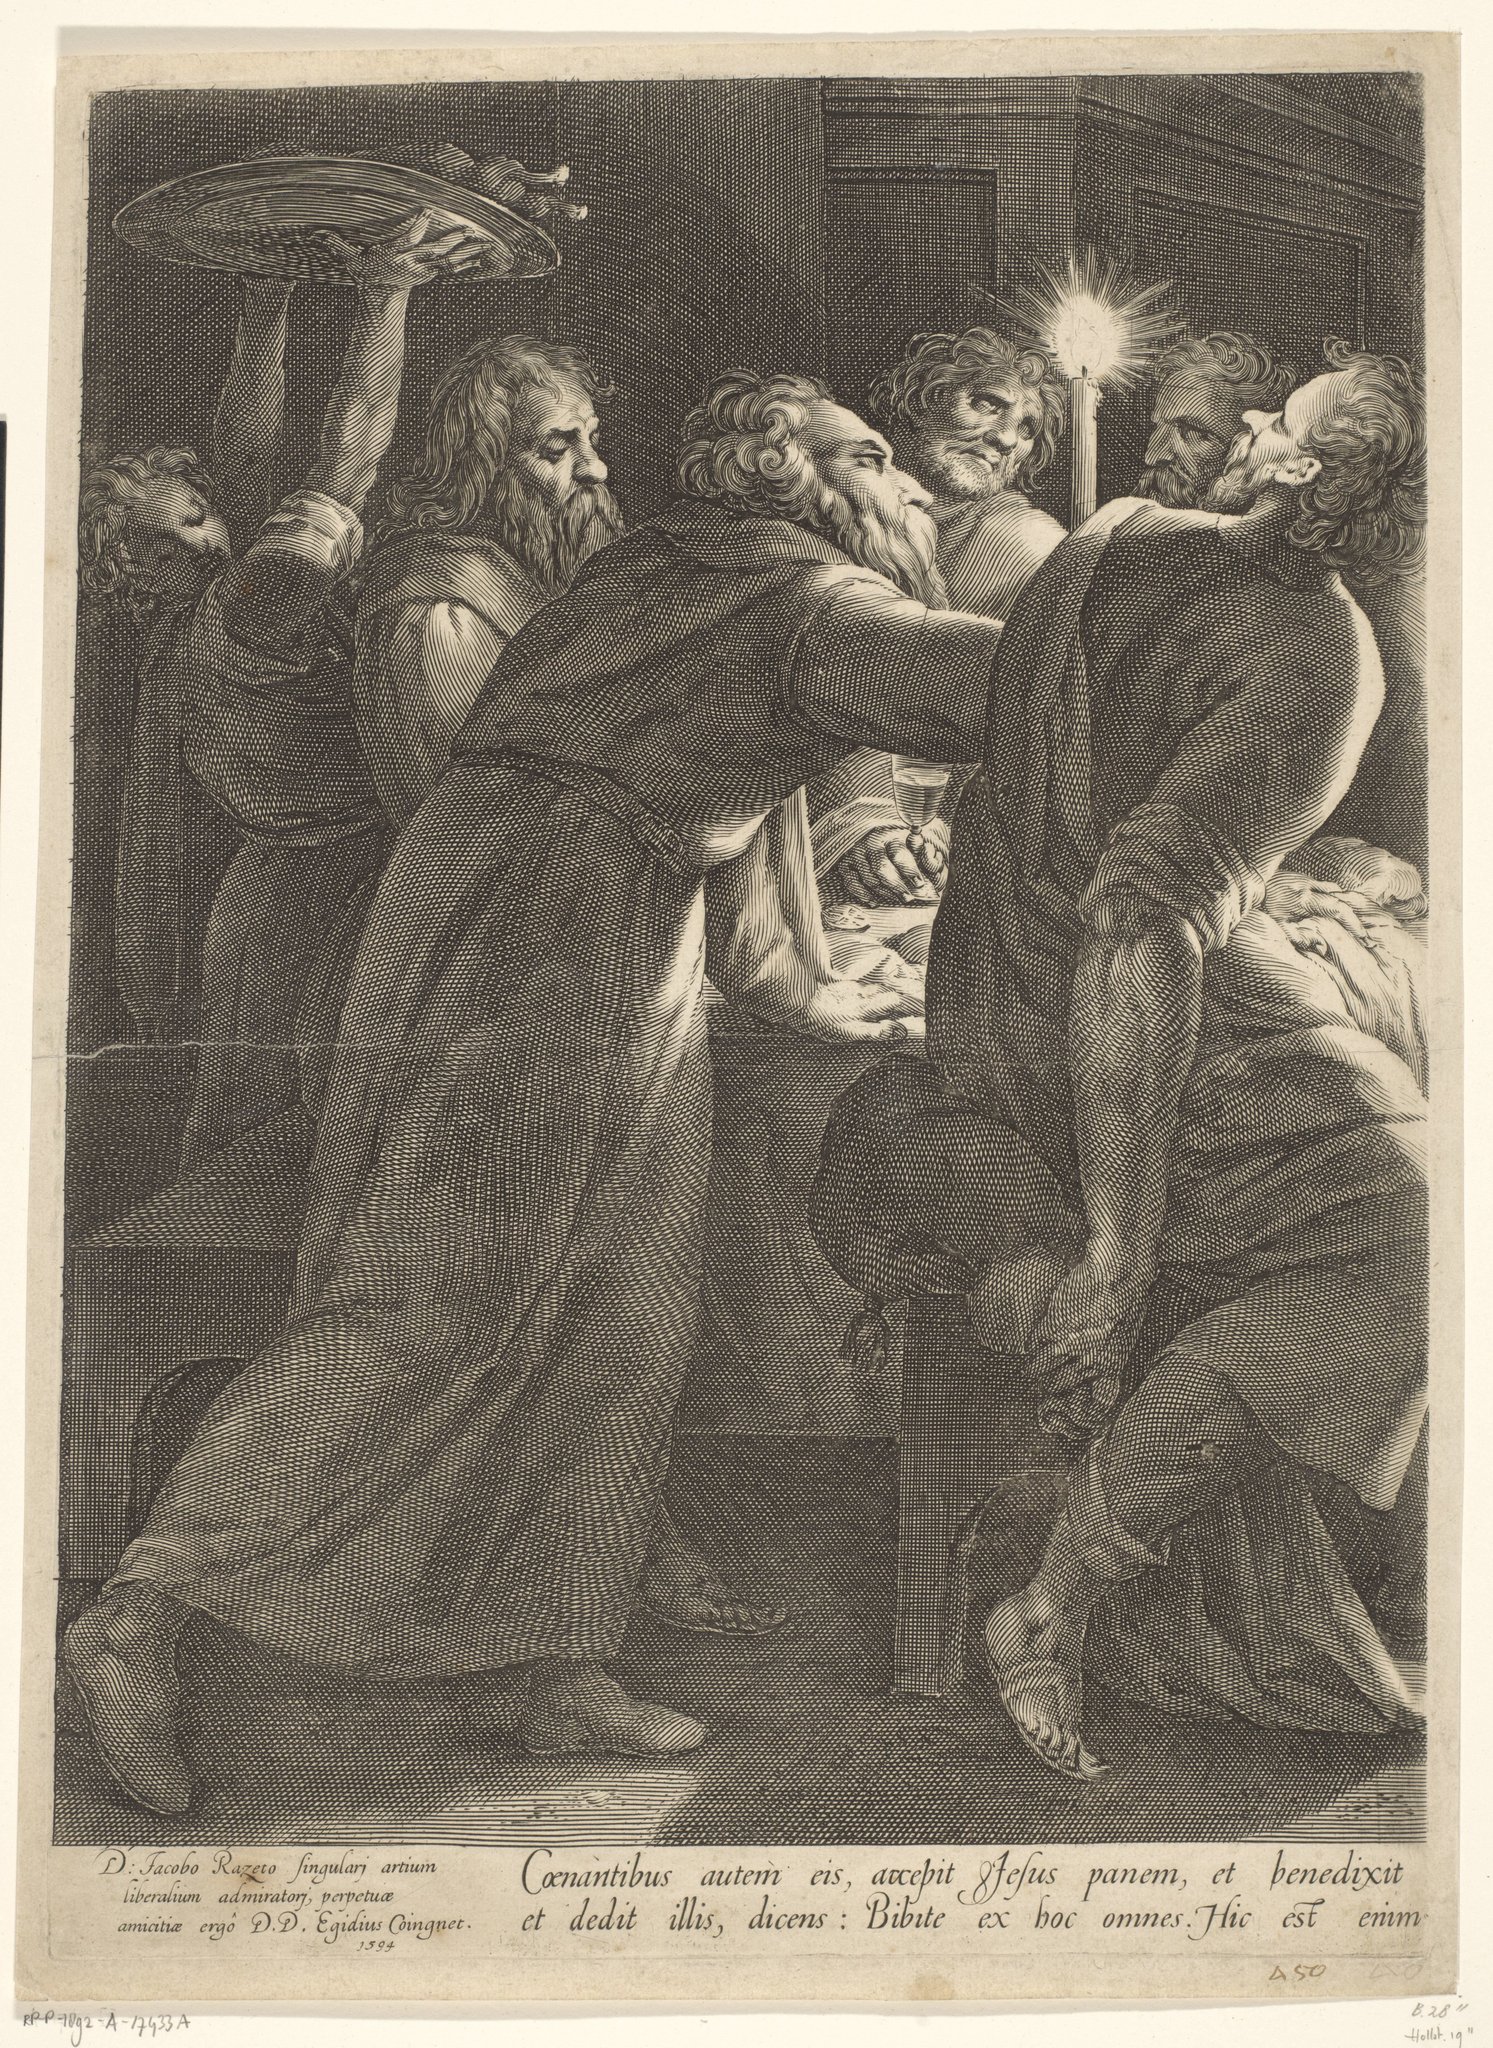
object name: print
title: Laatste avondmaal (linker blad)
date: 1594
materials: paper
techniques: engraving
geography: amsterdam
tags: announcement of the betrayal of christ, and the reaction of the apostles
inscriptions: collector's mark: Lugt 2228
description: Vijf discipelen aan tafel bij het laatste avondmaal. Links brengt een vrouw een schaal met eten binnen. Rechts houdt Judas de zak met zilverstukken achter zijn rug.